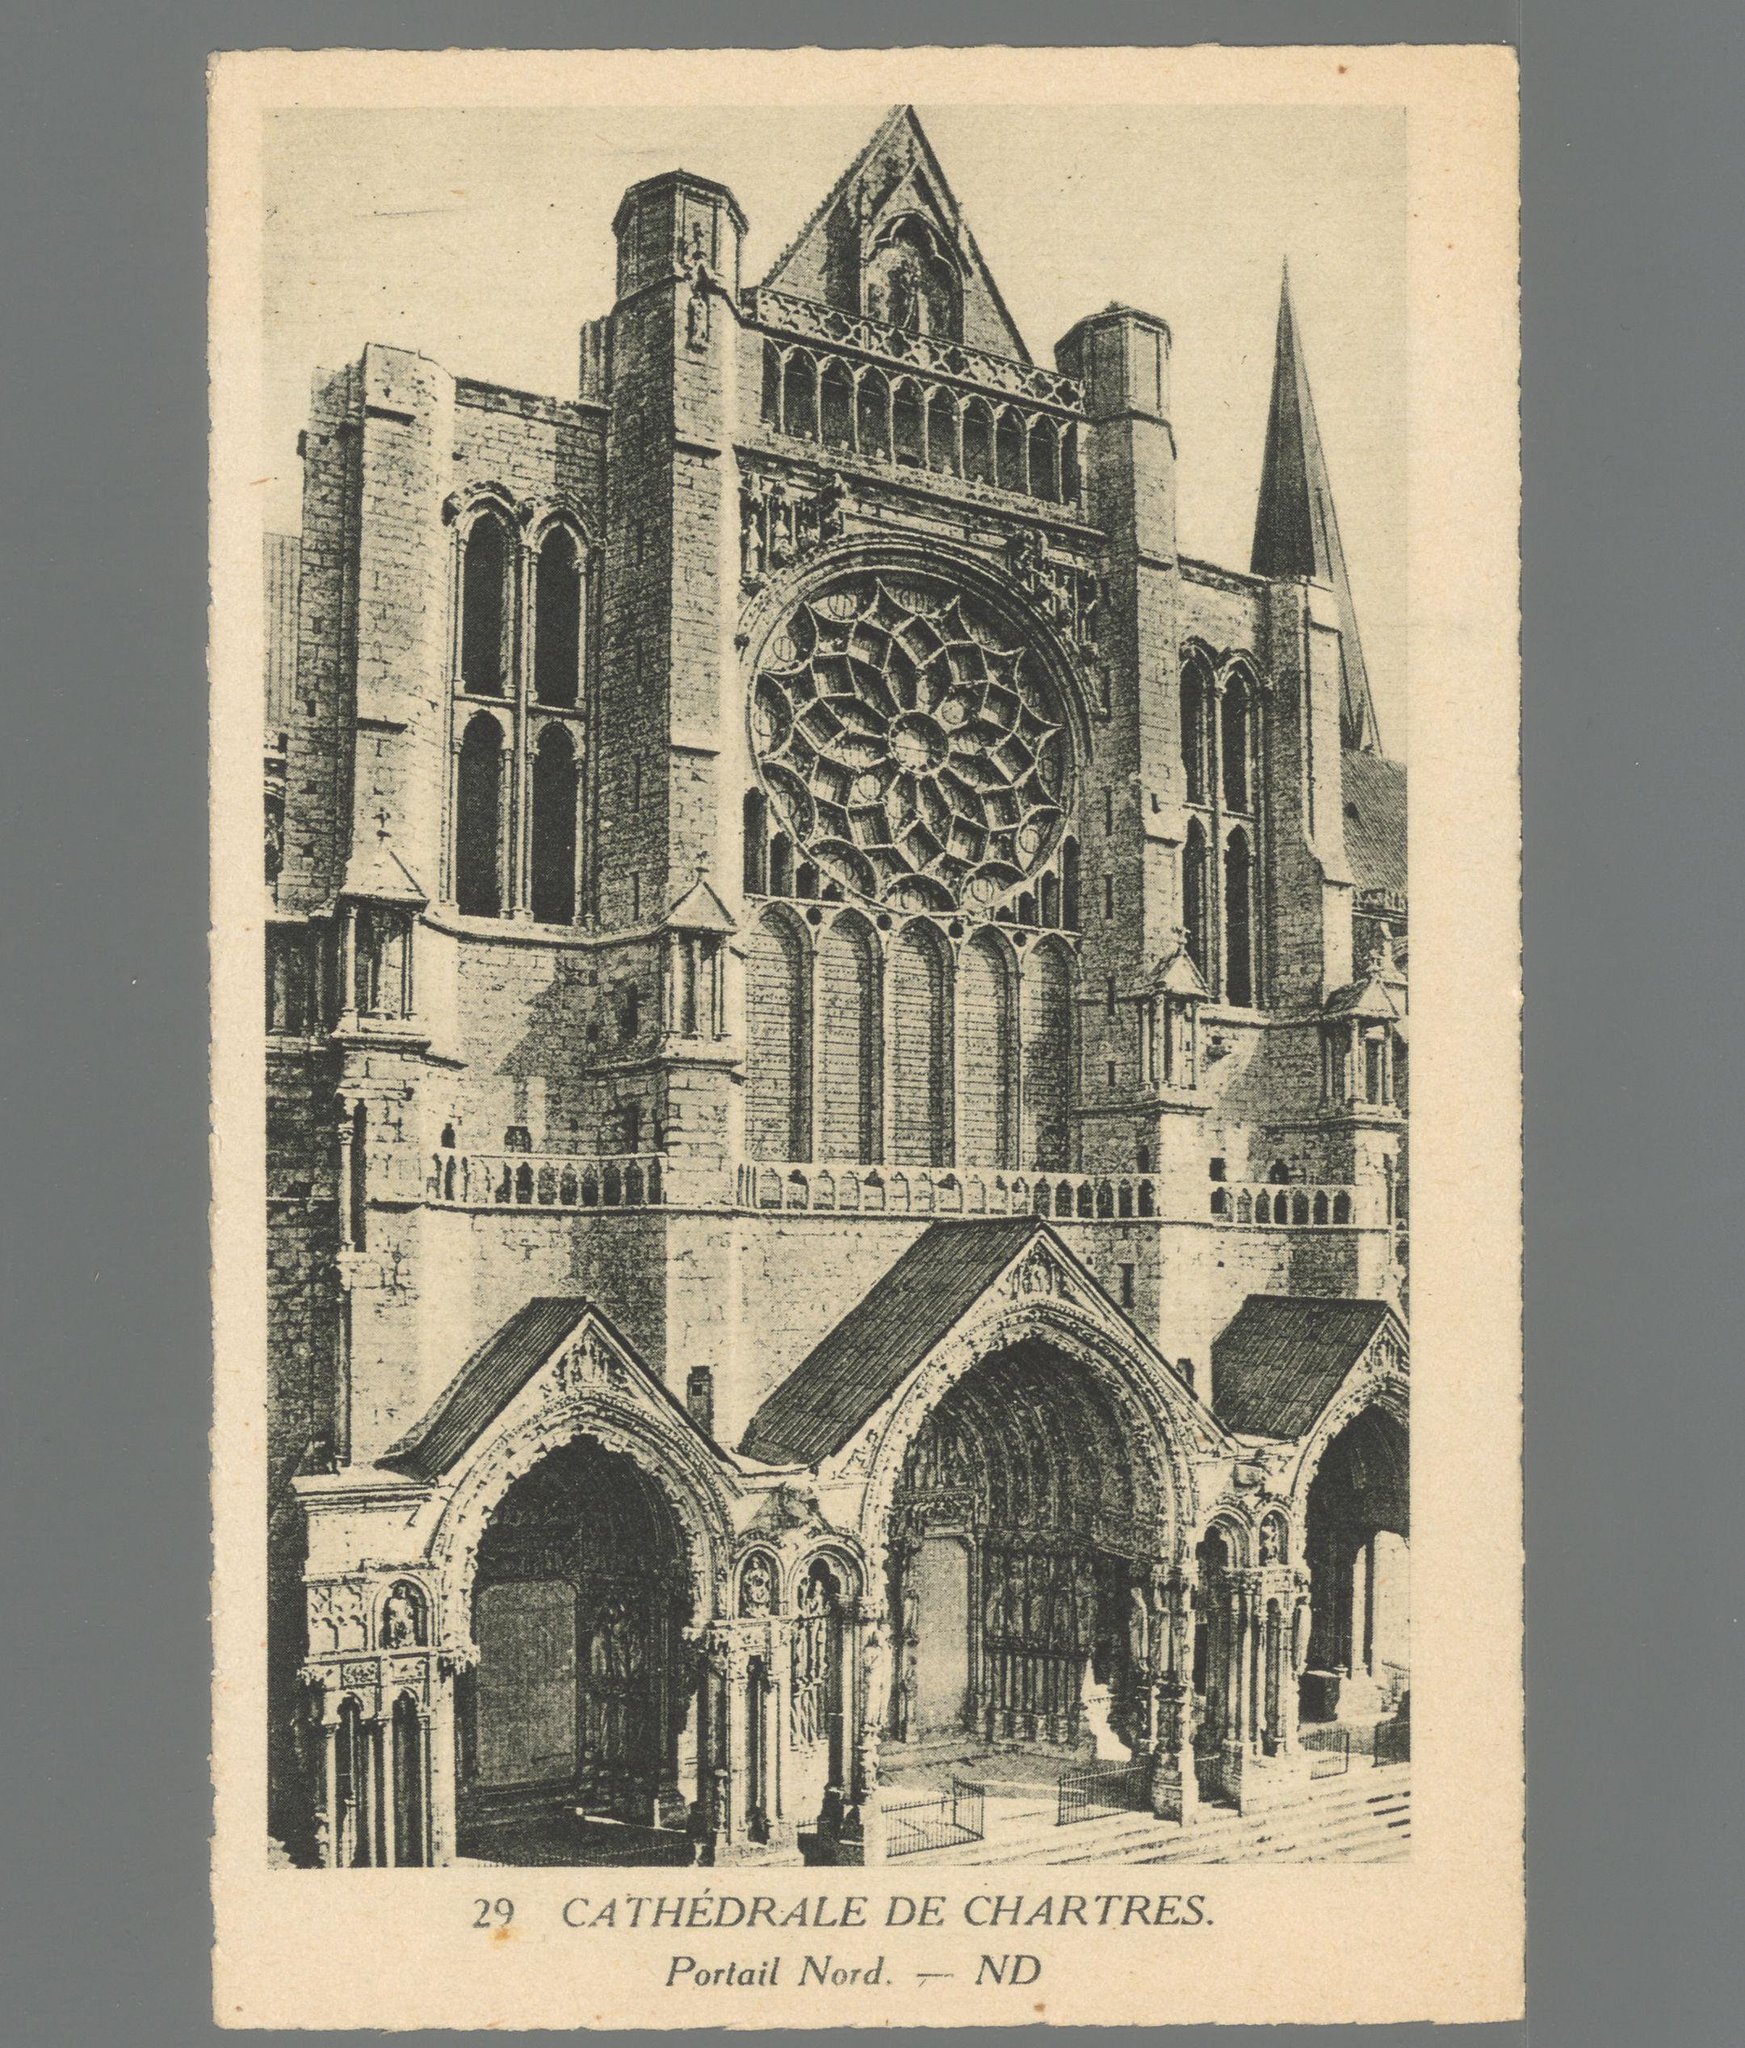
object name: ansichtkaart, prentbriefkaart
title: Cathédrale de Chartres - Portail Nord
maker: Anonymous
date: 1920-1932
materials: cardboard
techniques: rotogravure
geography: paris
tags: church (exterior), gate, entrance